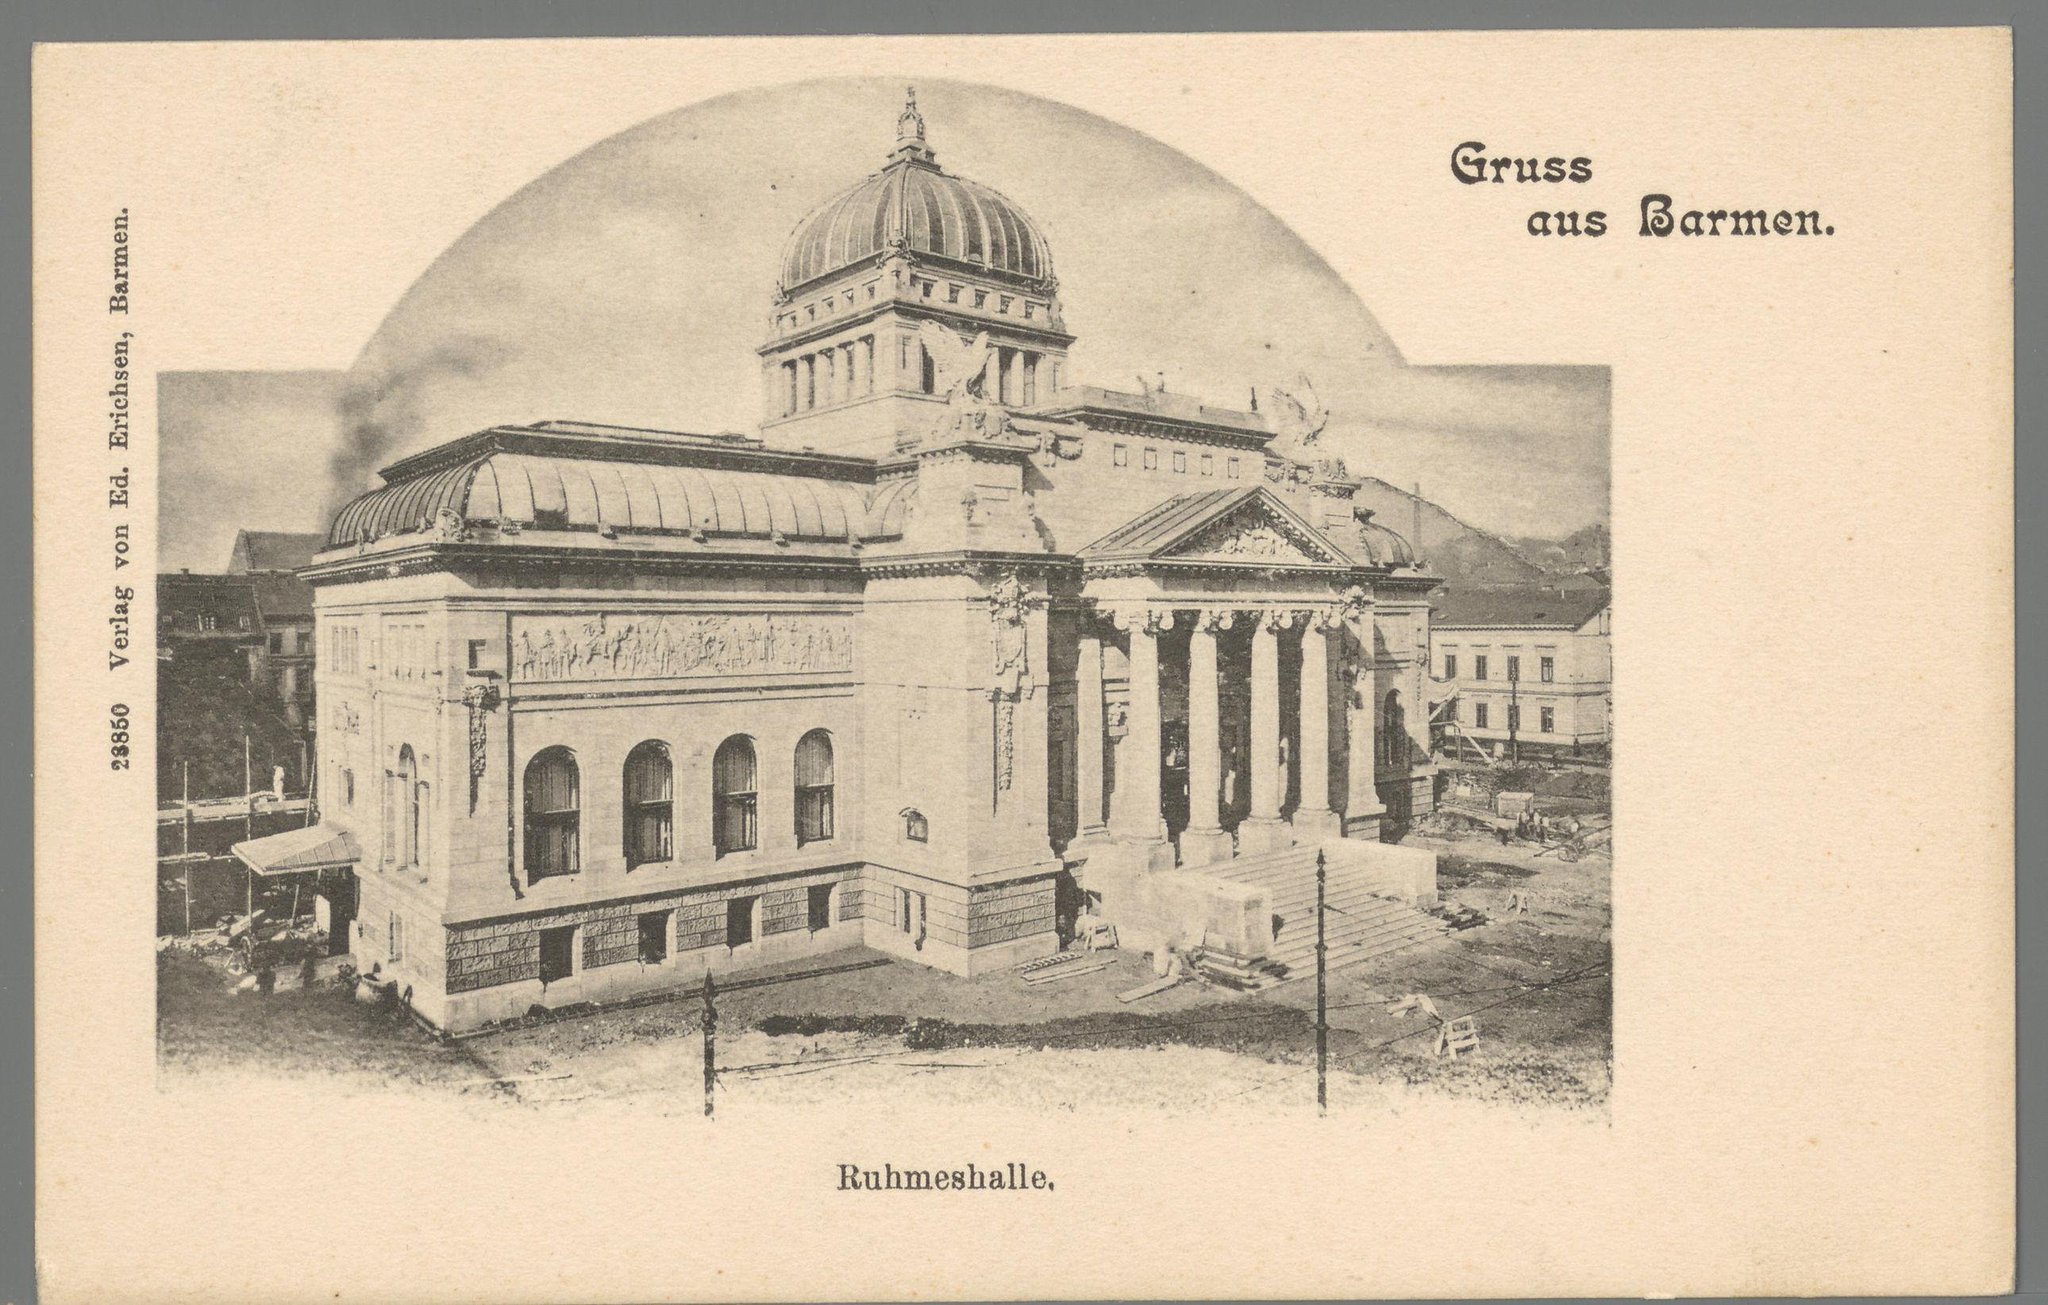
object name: photomechanical print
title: Gruss aus Barmen. Ruhmeshalle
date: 1890-1905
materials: cardboard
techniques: photograph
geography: barmen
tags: permanent exhibition, museum